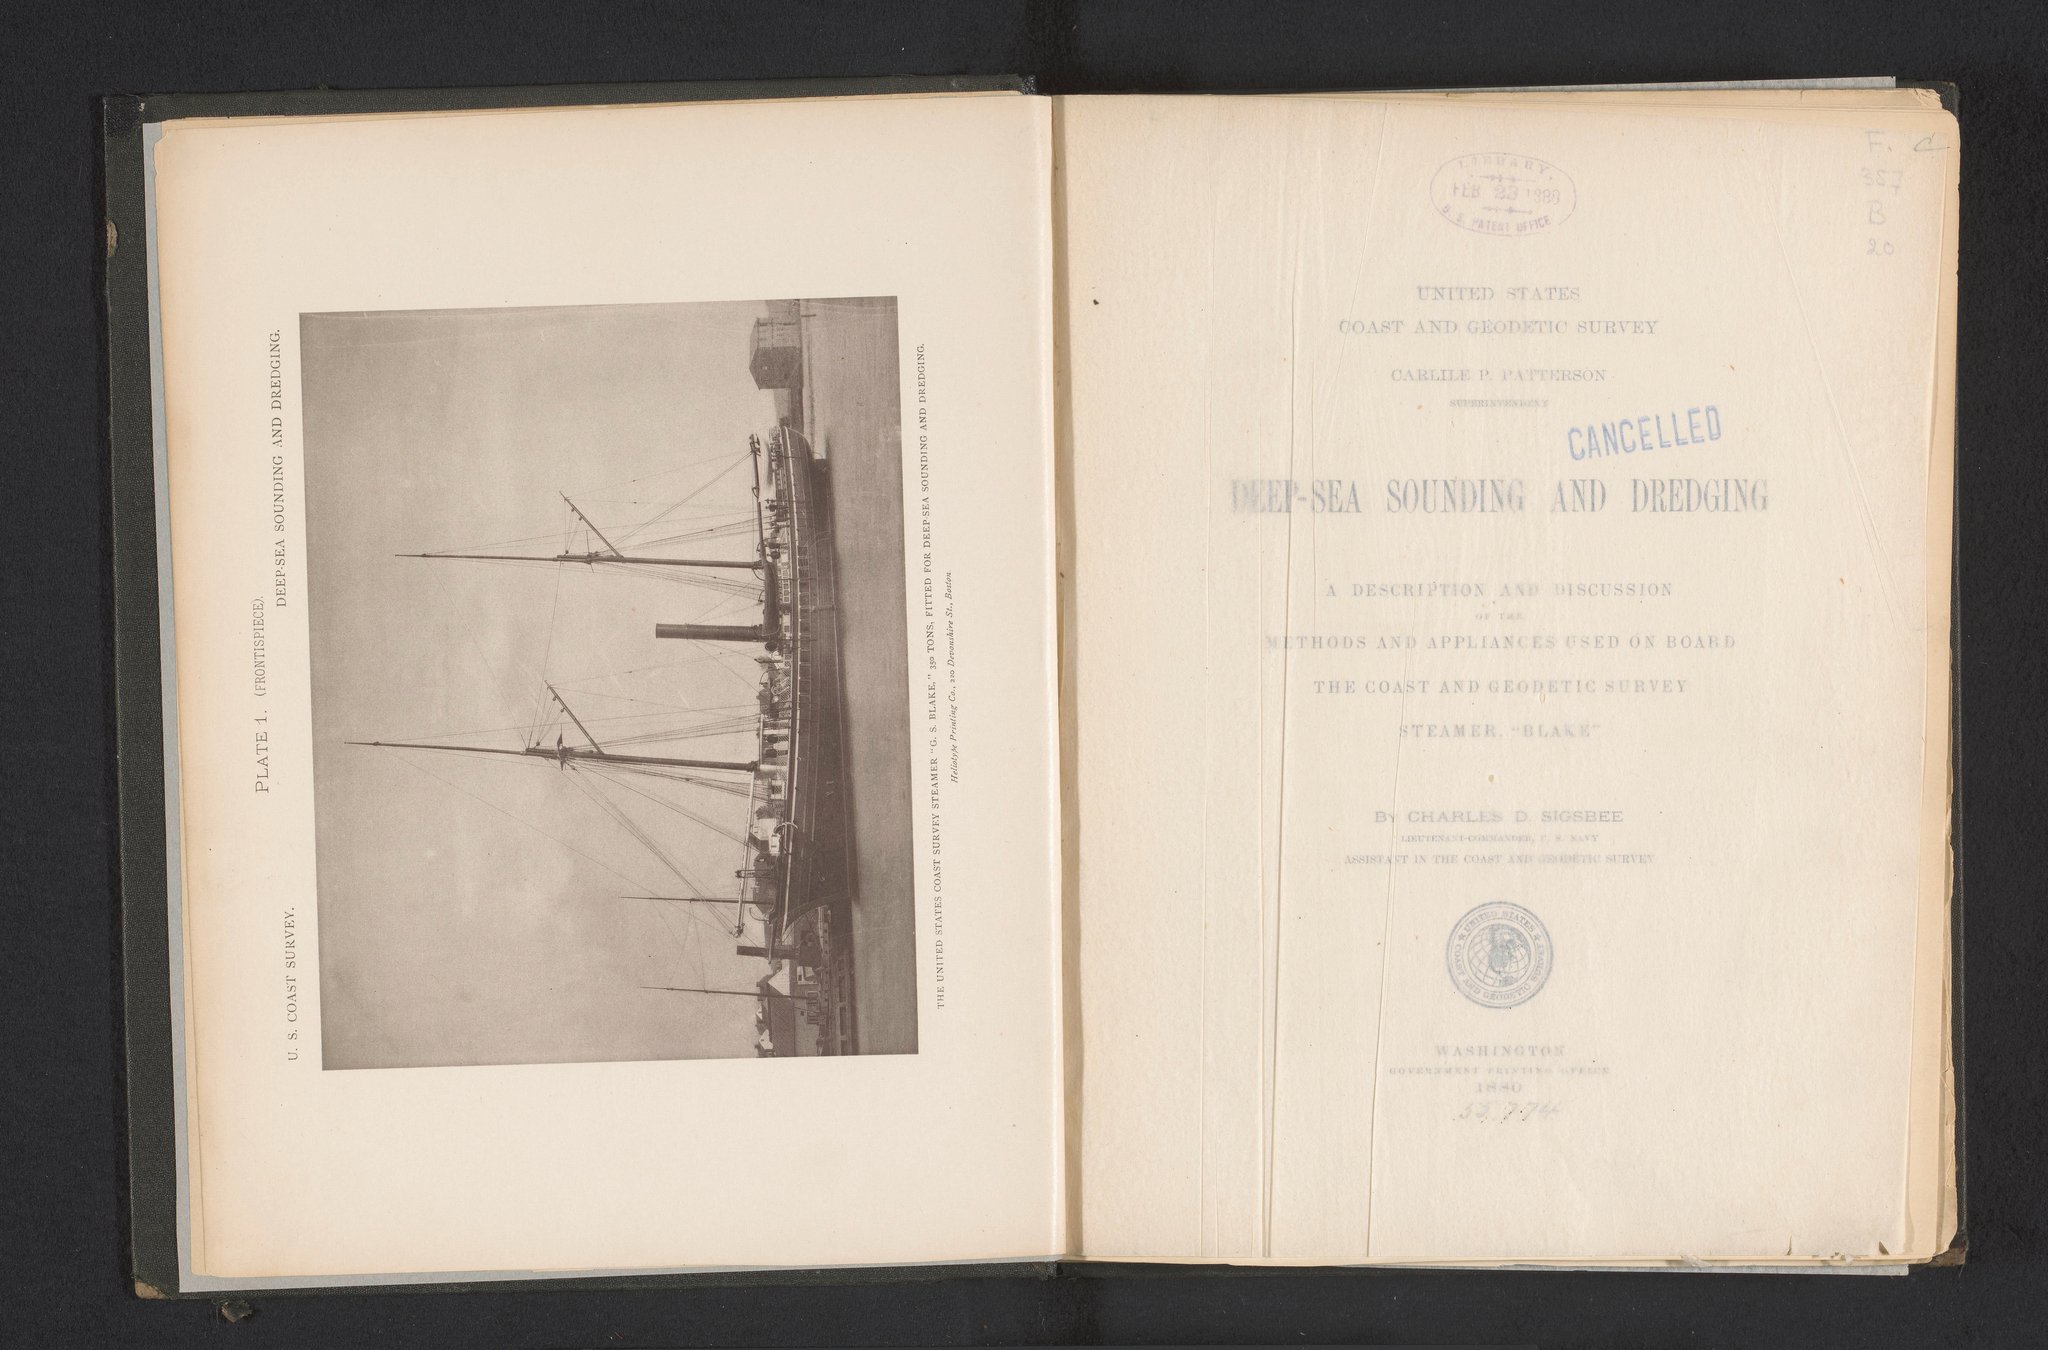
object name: page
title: Gezicht op het stoomschip George S. Blake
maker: Anonymous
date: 1870-1880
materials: paper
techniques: photograph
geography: boston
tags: steamship, motorship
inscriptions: inscription: ‘The United States coast survey steamer "G. S. Blake," 350 tons, fitted for deep-sea sounding and dredging’, name: ‘Heliotype Printing Co., 220 Devonshire St., Boston.’, number: ‘Plate 1.’